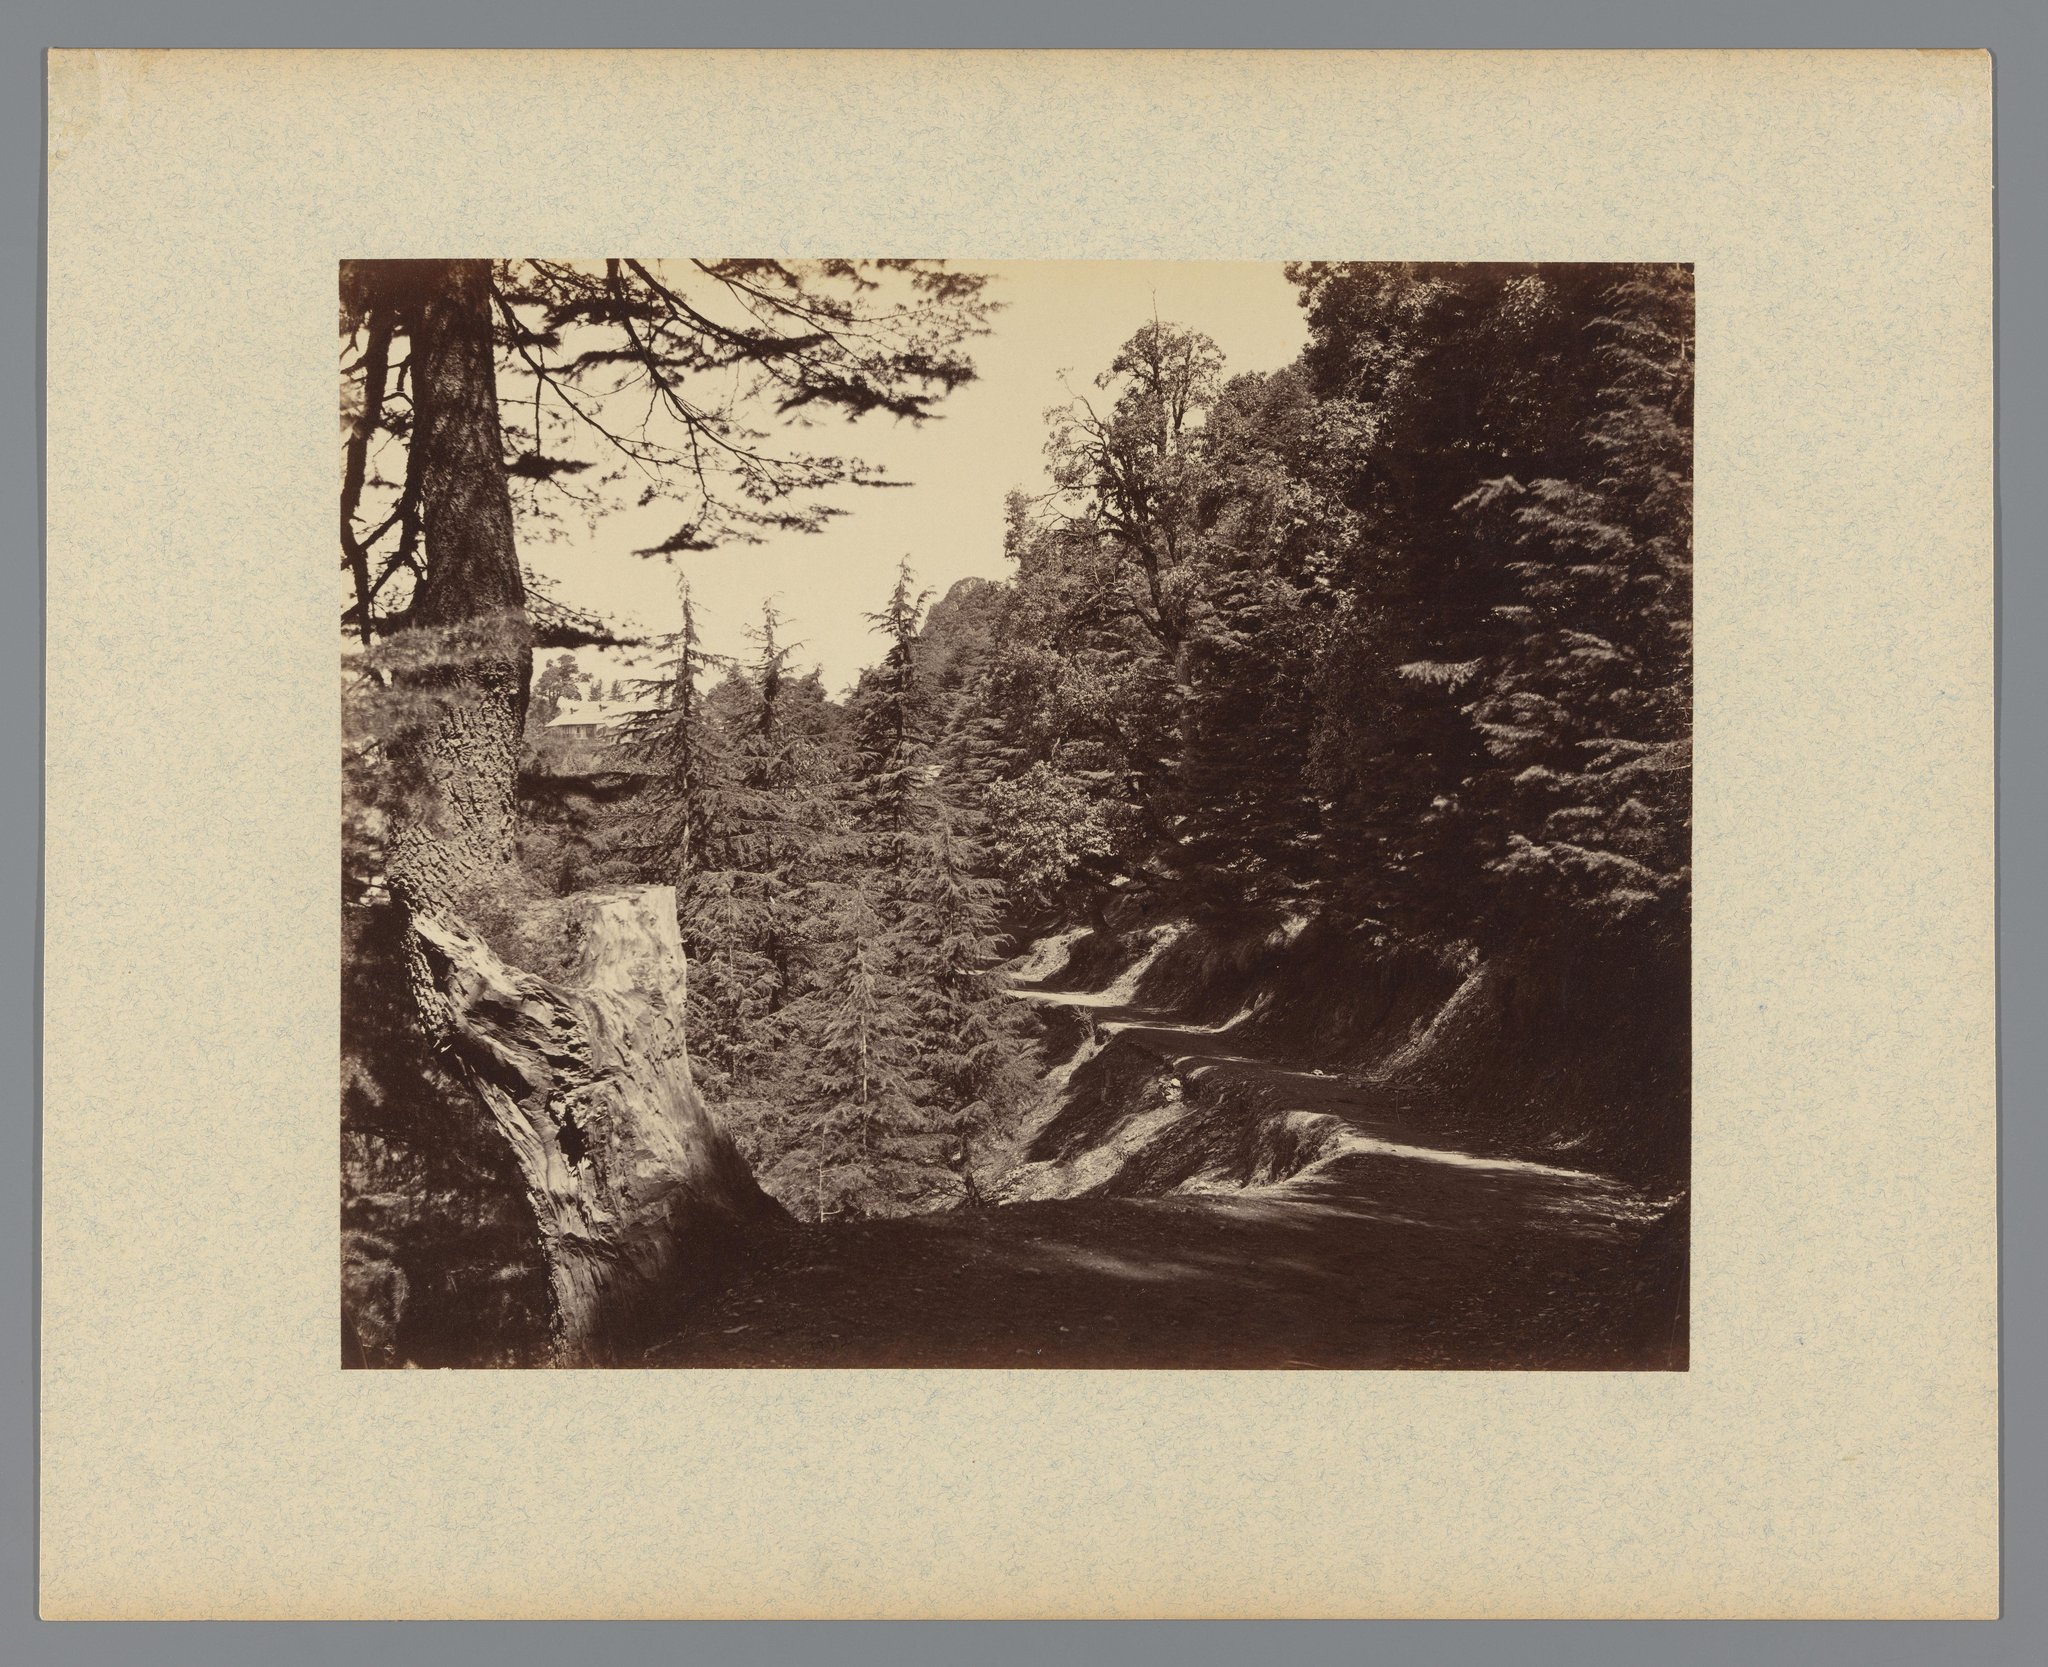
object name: photograph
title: Mountain landscape in India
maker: samuel bourne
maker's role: fotograaf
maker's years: 1834-1912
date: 1860-1912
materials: cardboard, paper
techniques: albumen print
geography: india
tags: india